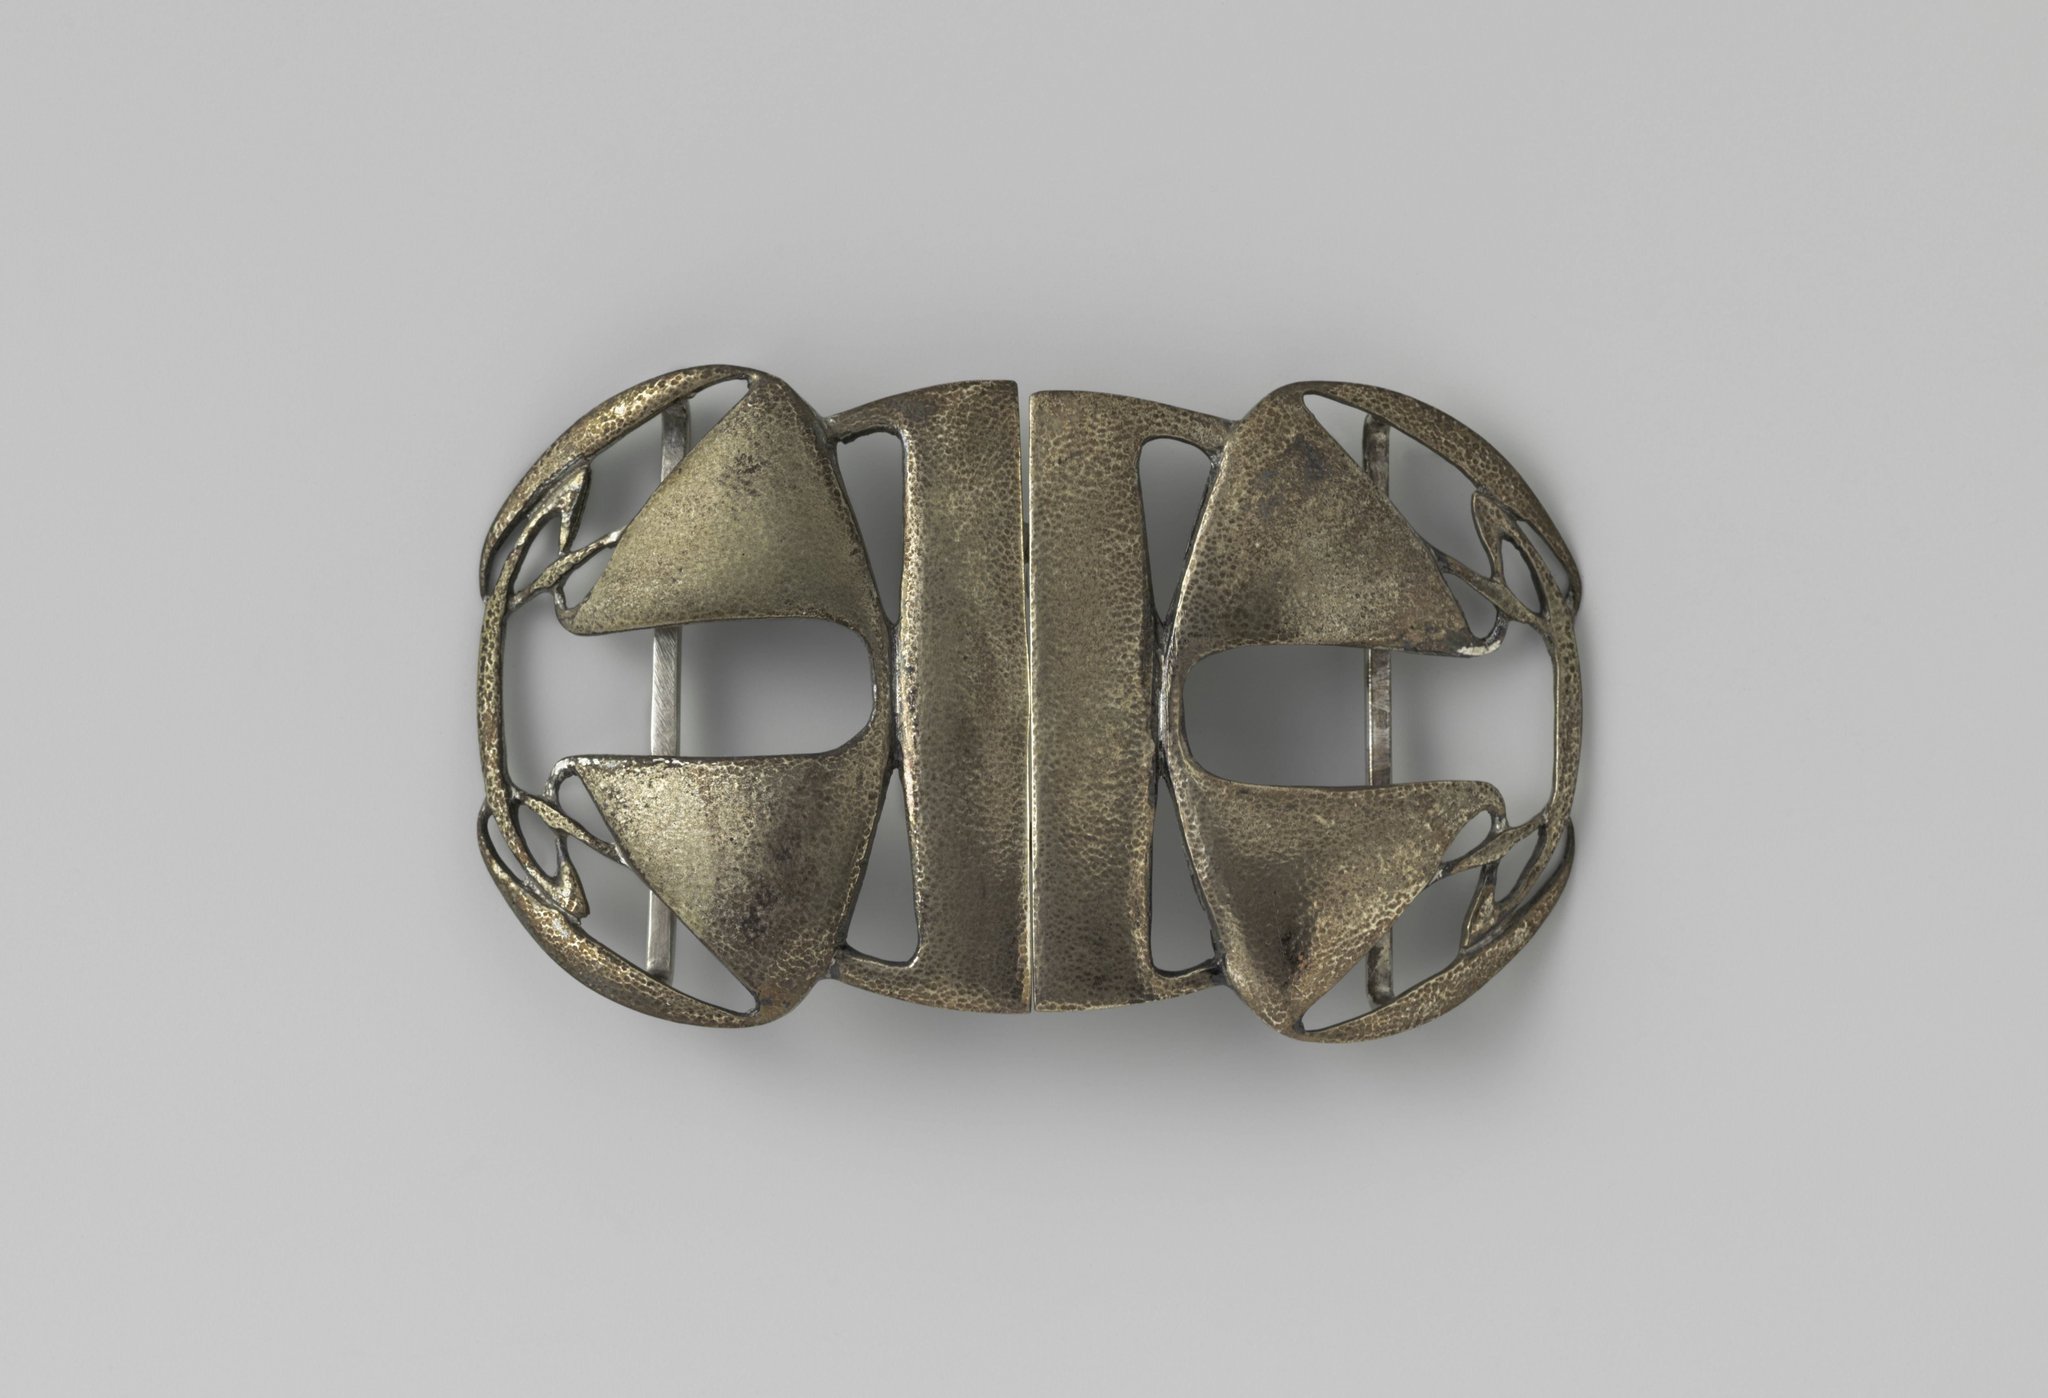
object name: jewellery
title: Gesp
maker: archibald knox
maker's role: goldsmith, painter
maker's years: 1864-1933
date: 1902-1903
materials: silver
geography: birmingham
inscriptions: maker's mark: ‘L&Co’, town mark: ‘anker’, date letter: ‘C’, alloy mark: ‘lopende leeuw naar links’, mark: ‘CYMRIC in rechthoek’, mark: ‘8’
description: Gesp van zilver. De gesp heeft een eenvoudige, abstracte, symmetrische vorm. In het zilver zit een hamerslagstructuur.